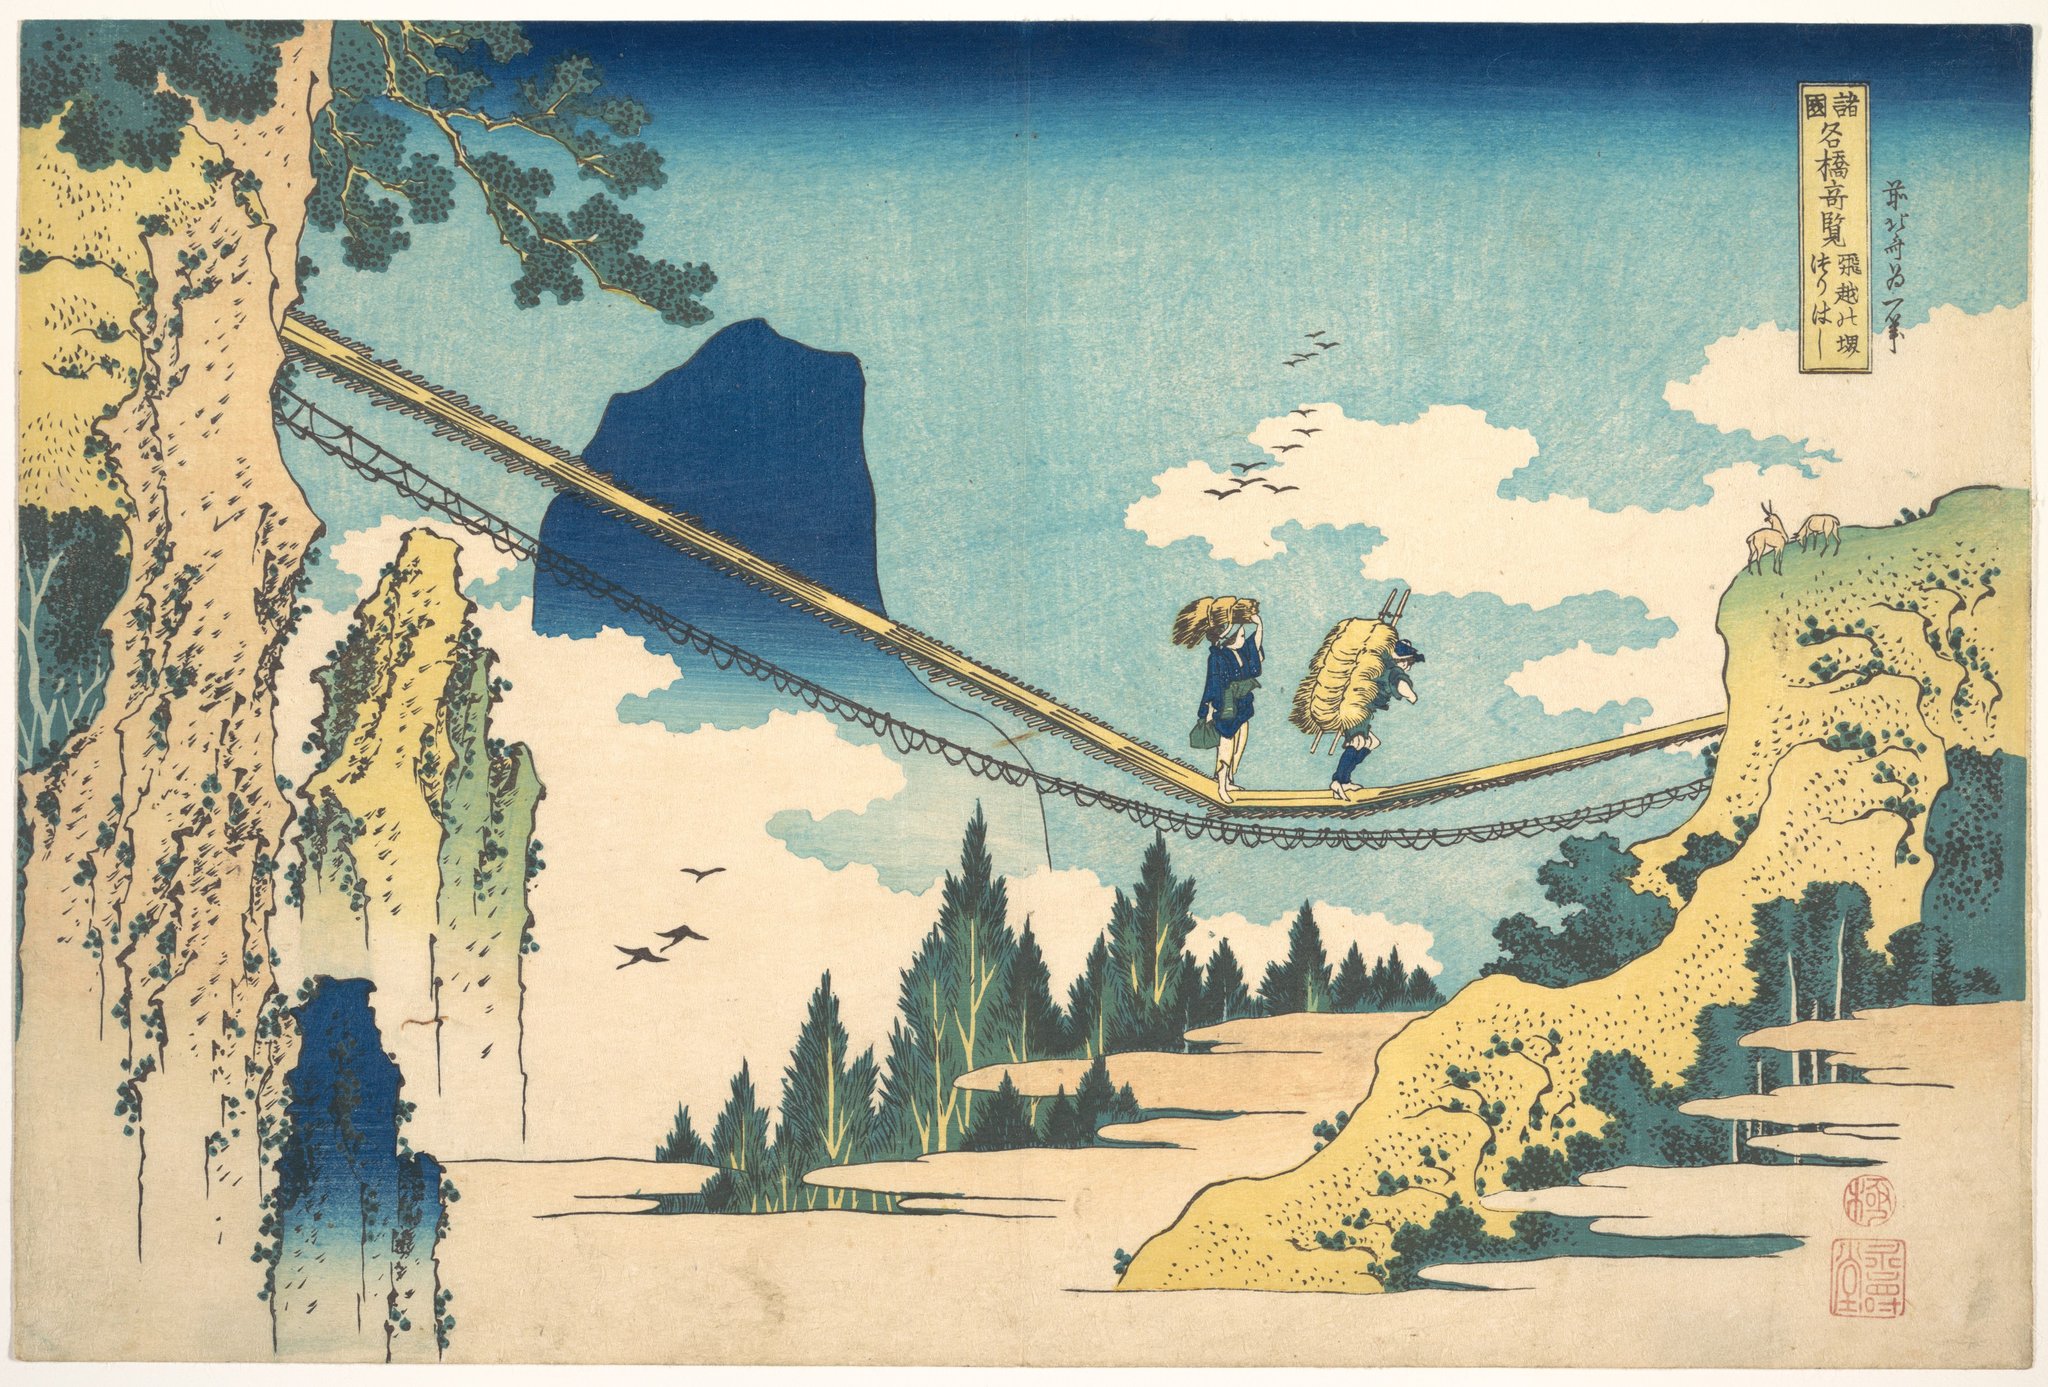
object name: woodblock print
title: The Suspension Bridge on the Border of Hida and Etchū Provinces (Hietsu no sakai tsuribashi), from the series Remarkable Views of Bridges in Various Provinces (Shokoku meikyō kiran)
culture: japanese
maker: katsushika hokusai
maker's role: artist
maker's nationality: japanese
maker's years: 1760-1849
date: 1830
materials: ink, paper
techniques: woodblock print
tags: human figures,bridges,mountains,trees